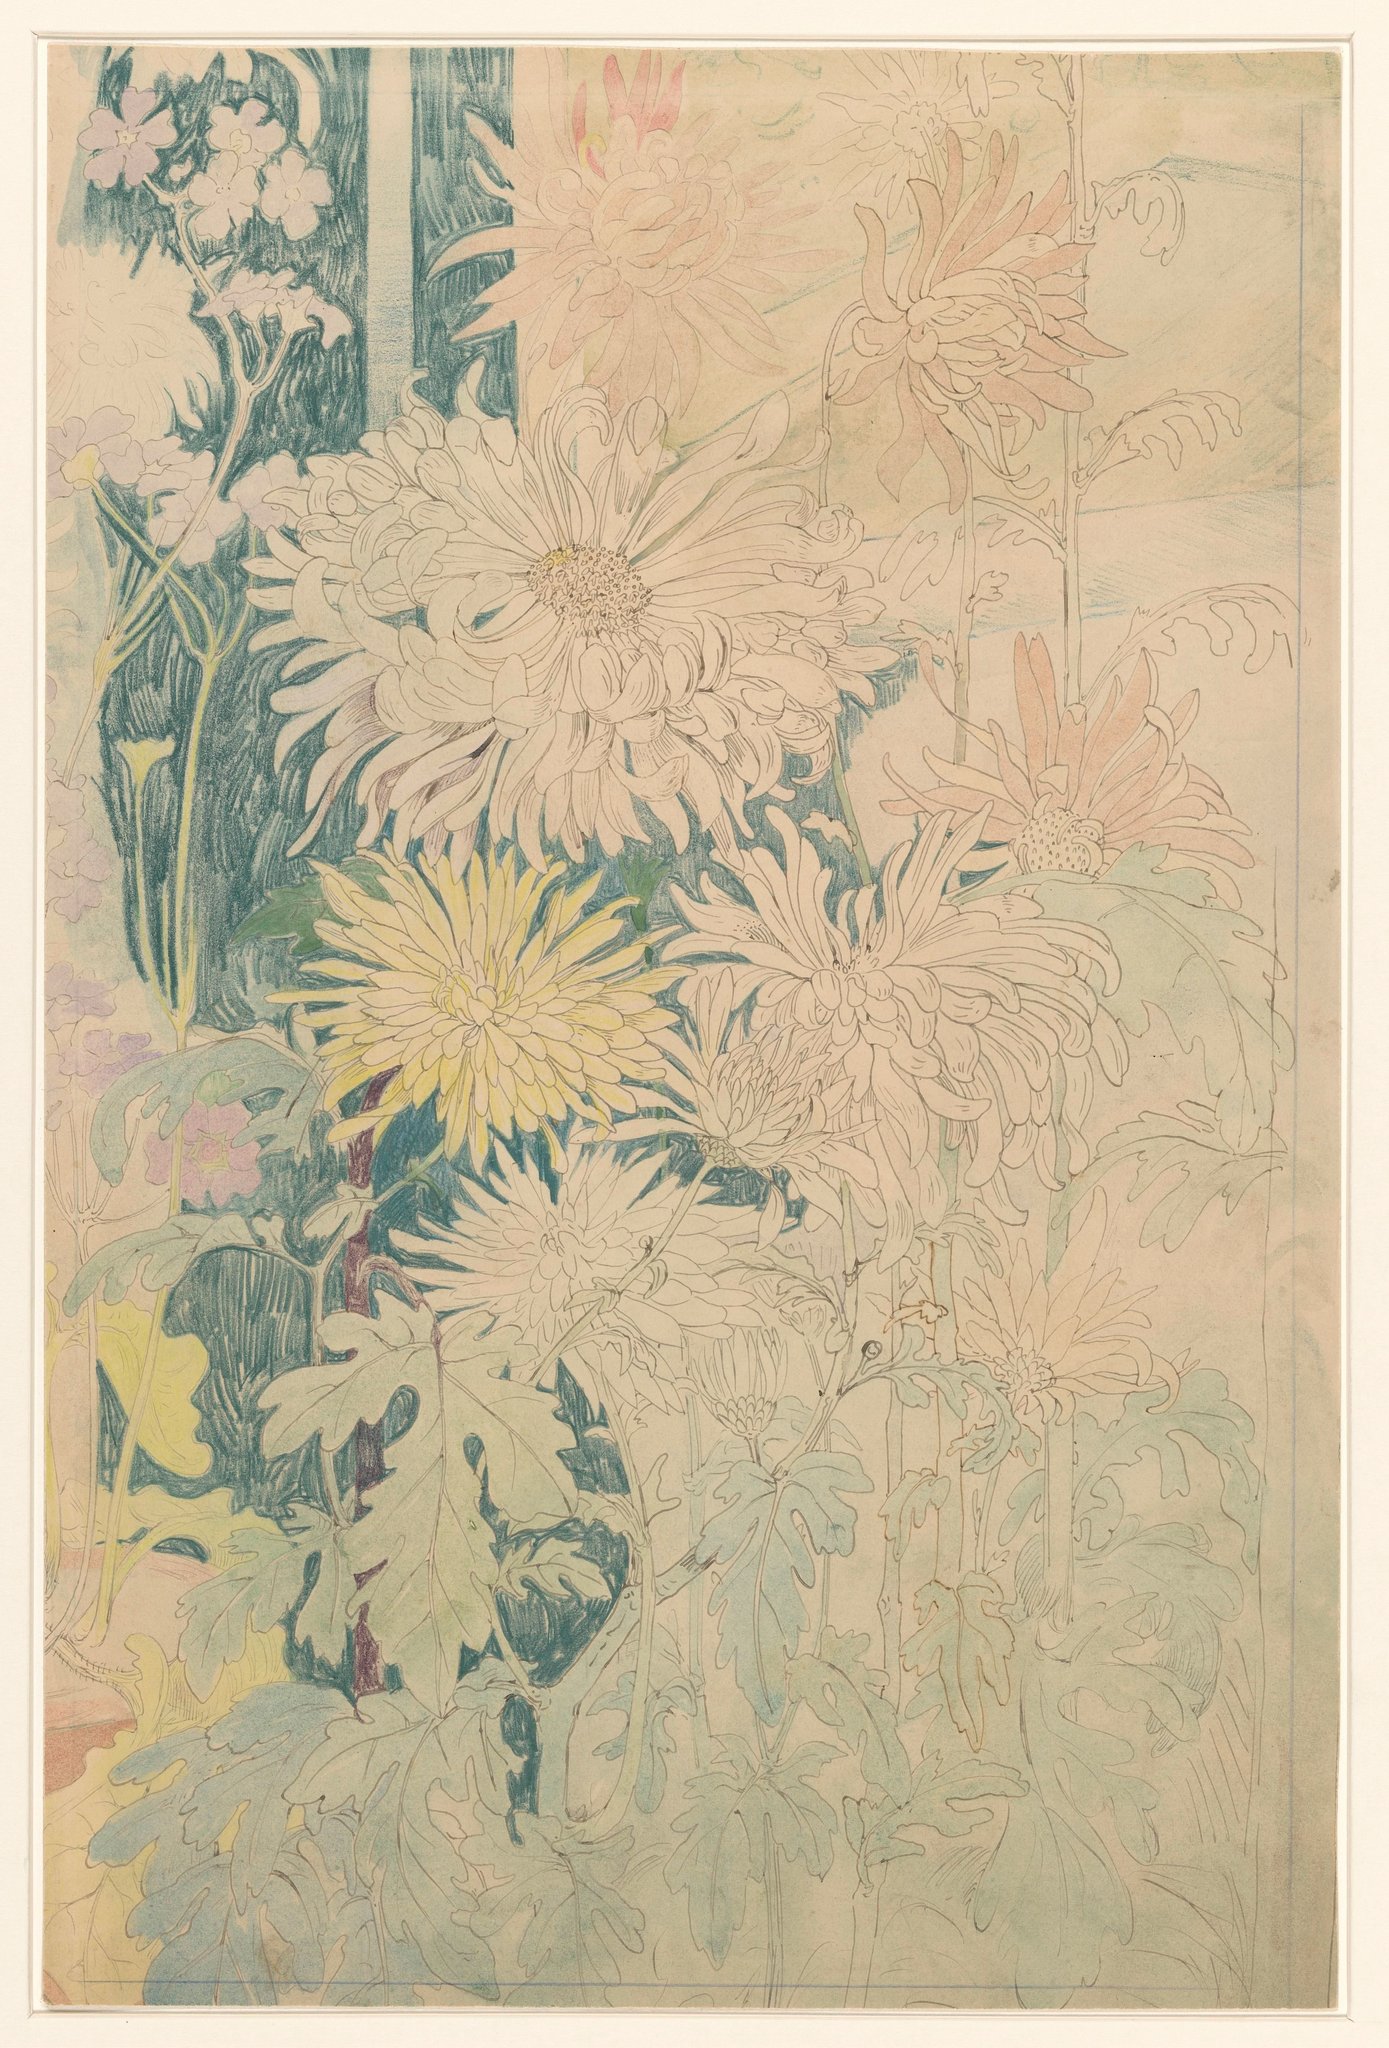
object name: drawing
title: Chrysanten en enkele andere herfstbloemen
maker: theo van hoytema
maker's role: draughtsman, painter, print maker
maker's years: 1863-1917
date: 1873-1917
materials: chalk, ink, paper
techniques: brush, pen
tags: flowers: chrysanthemum